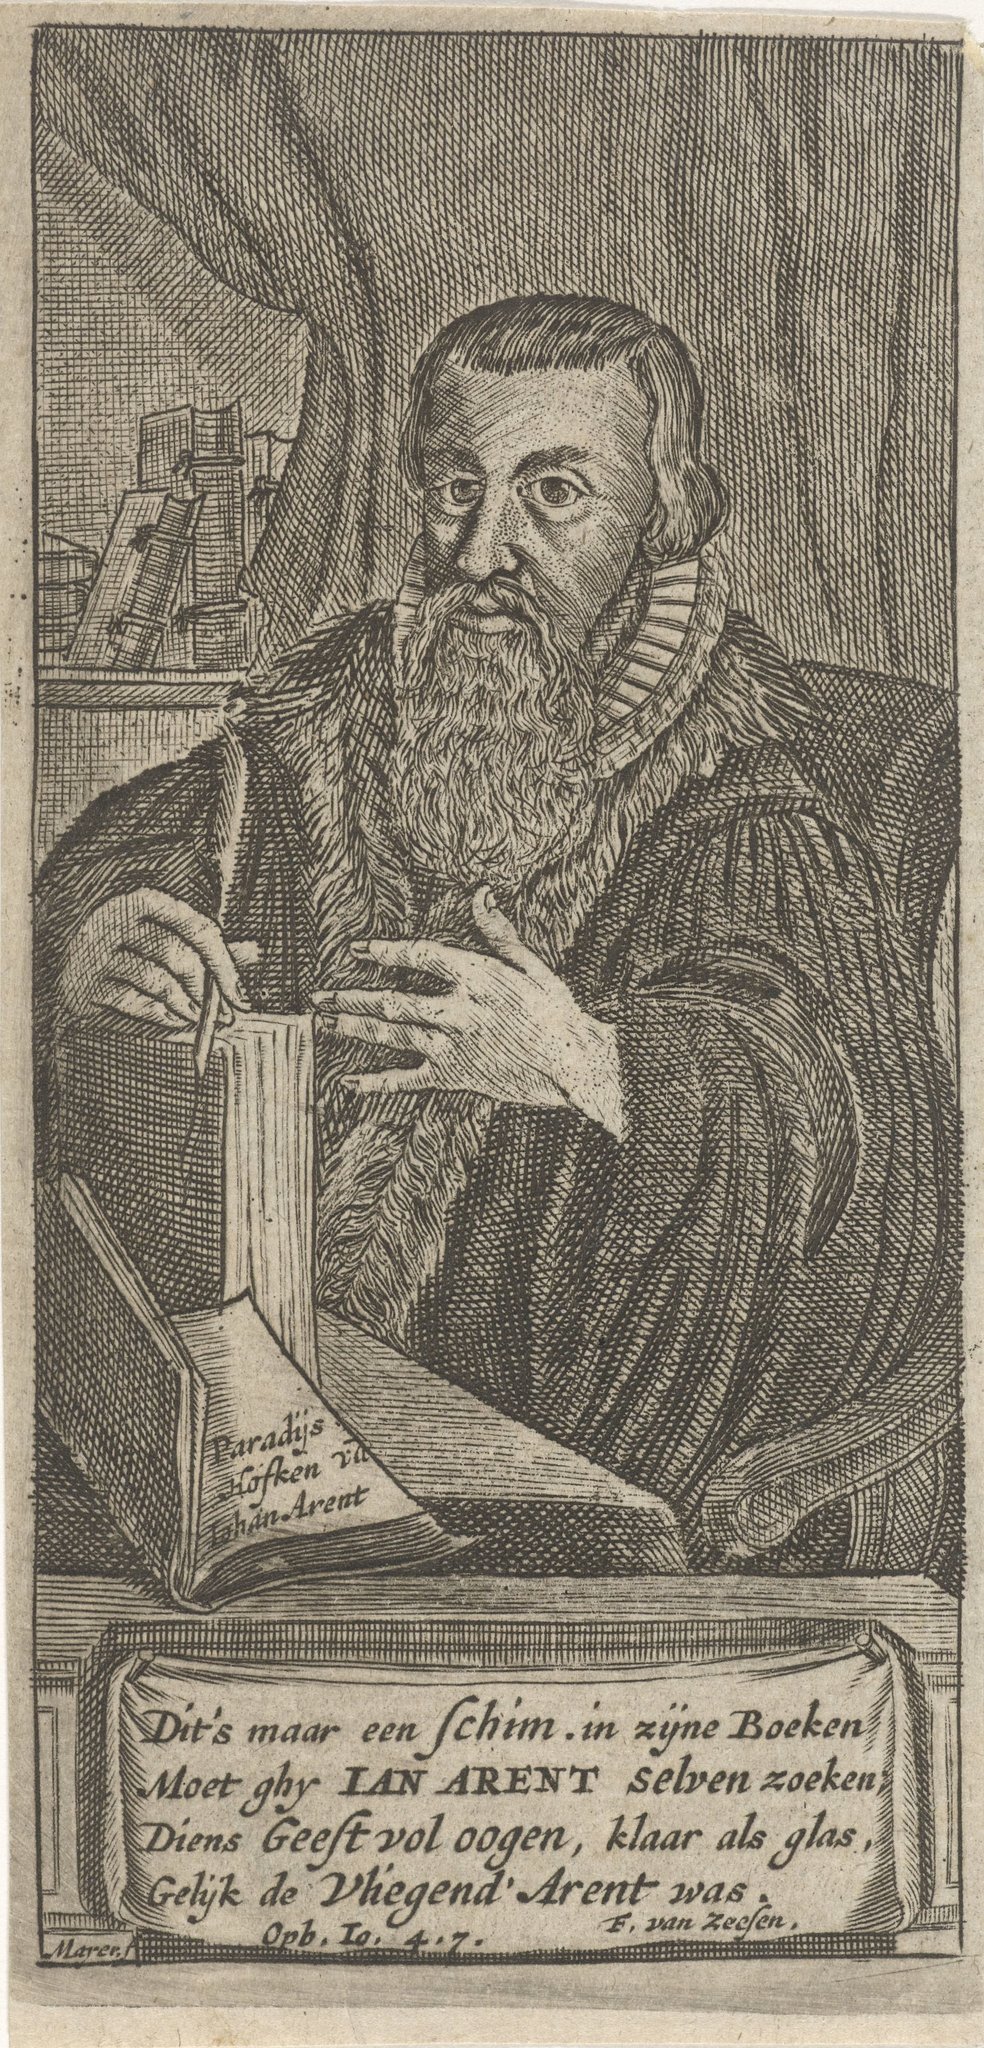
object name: print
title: Portret van Jan Arentsz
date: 1651-1701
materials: paper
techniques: engraving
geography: amsterdam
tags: writing tools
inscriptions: collector's mark: Lugt 2228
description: Portret van hageprediker Jan Arentsz in zijn studeerkamer met een schrijfveer in zijn hand.